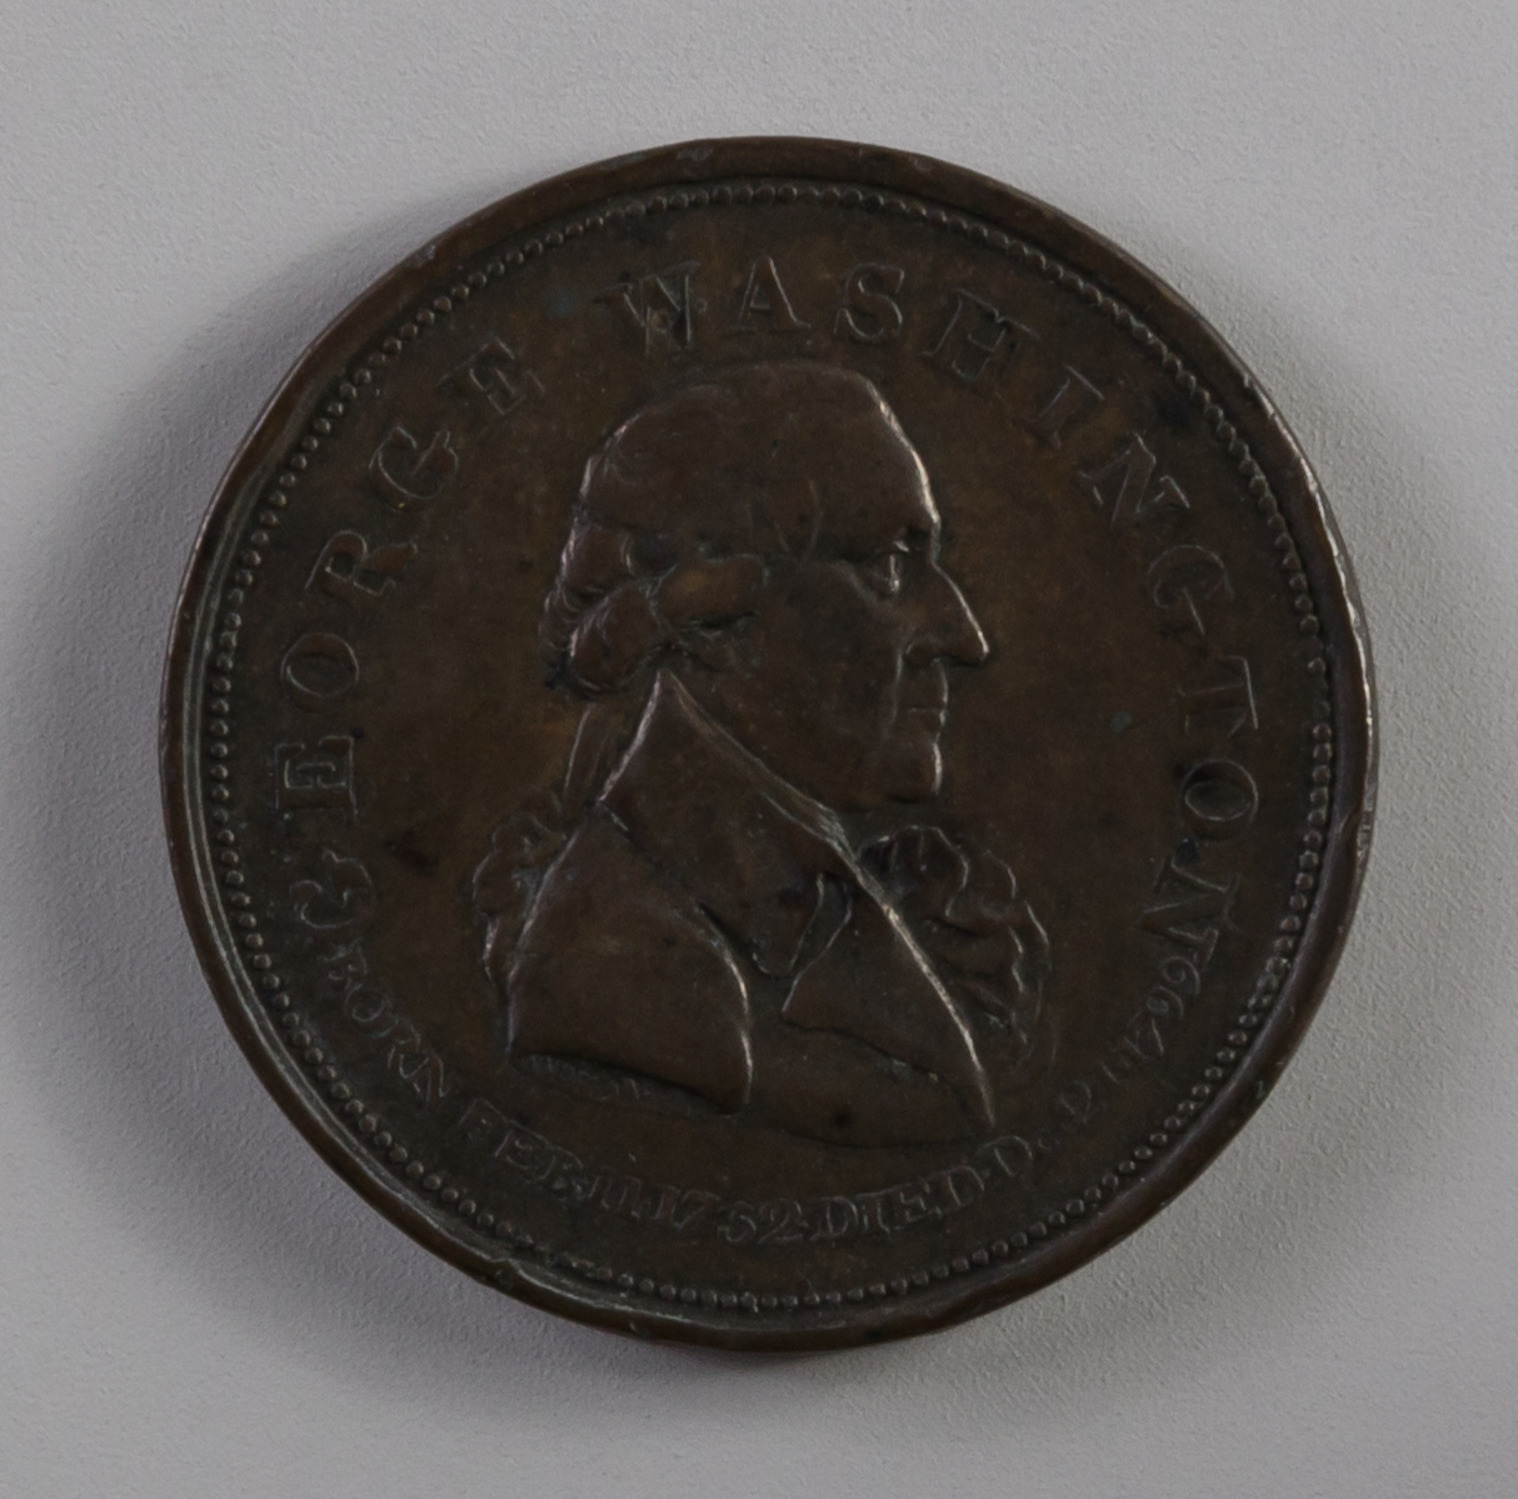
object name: medal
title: George Washington Commemorative Medal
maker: joseph s. and alfred wyon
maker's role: maker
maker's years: 1700-1900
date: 1800-1907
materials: bronze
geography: england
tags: george washington,profiles